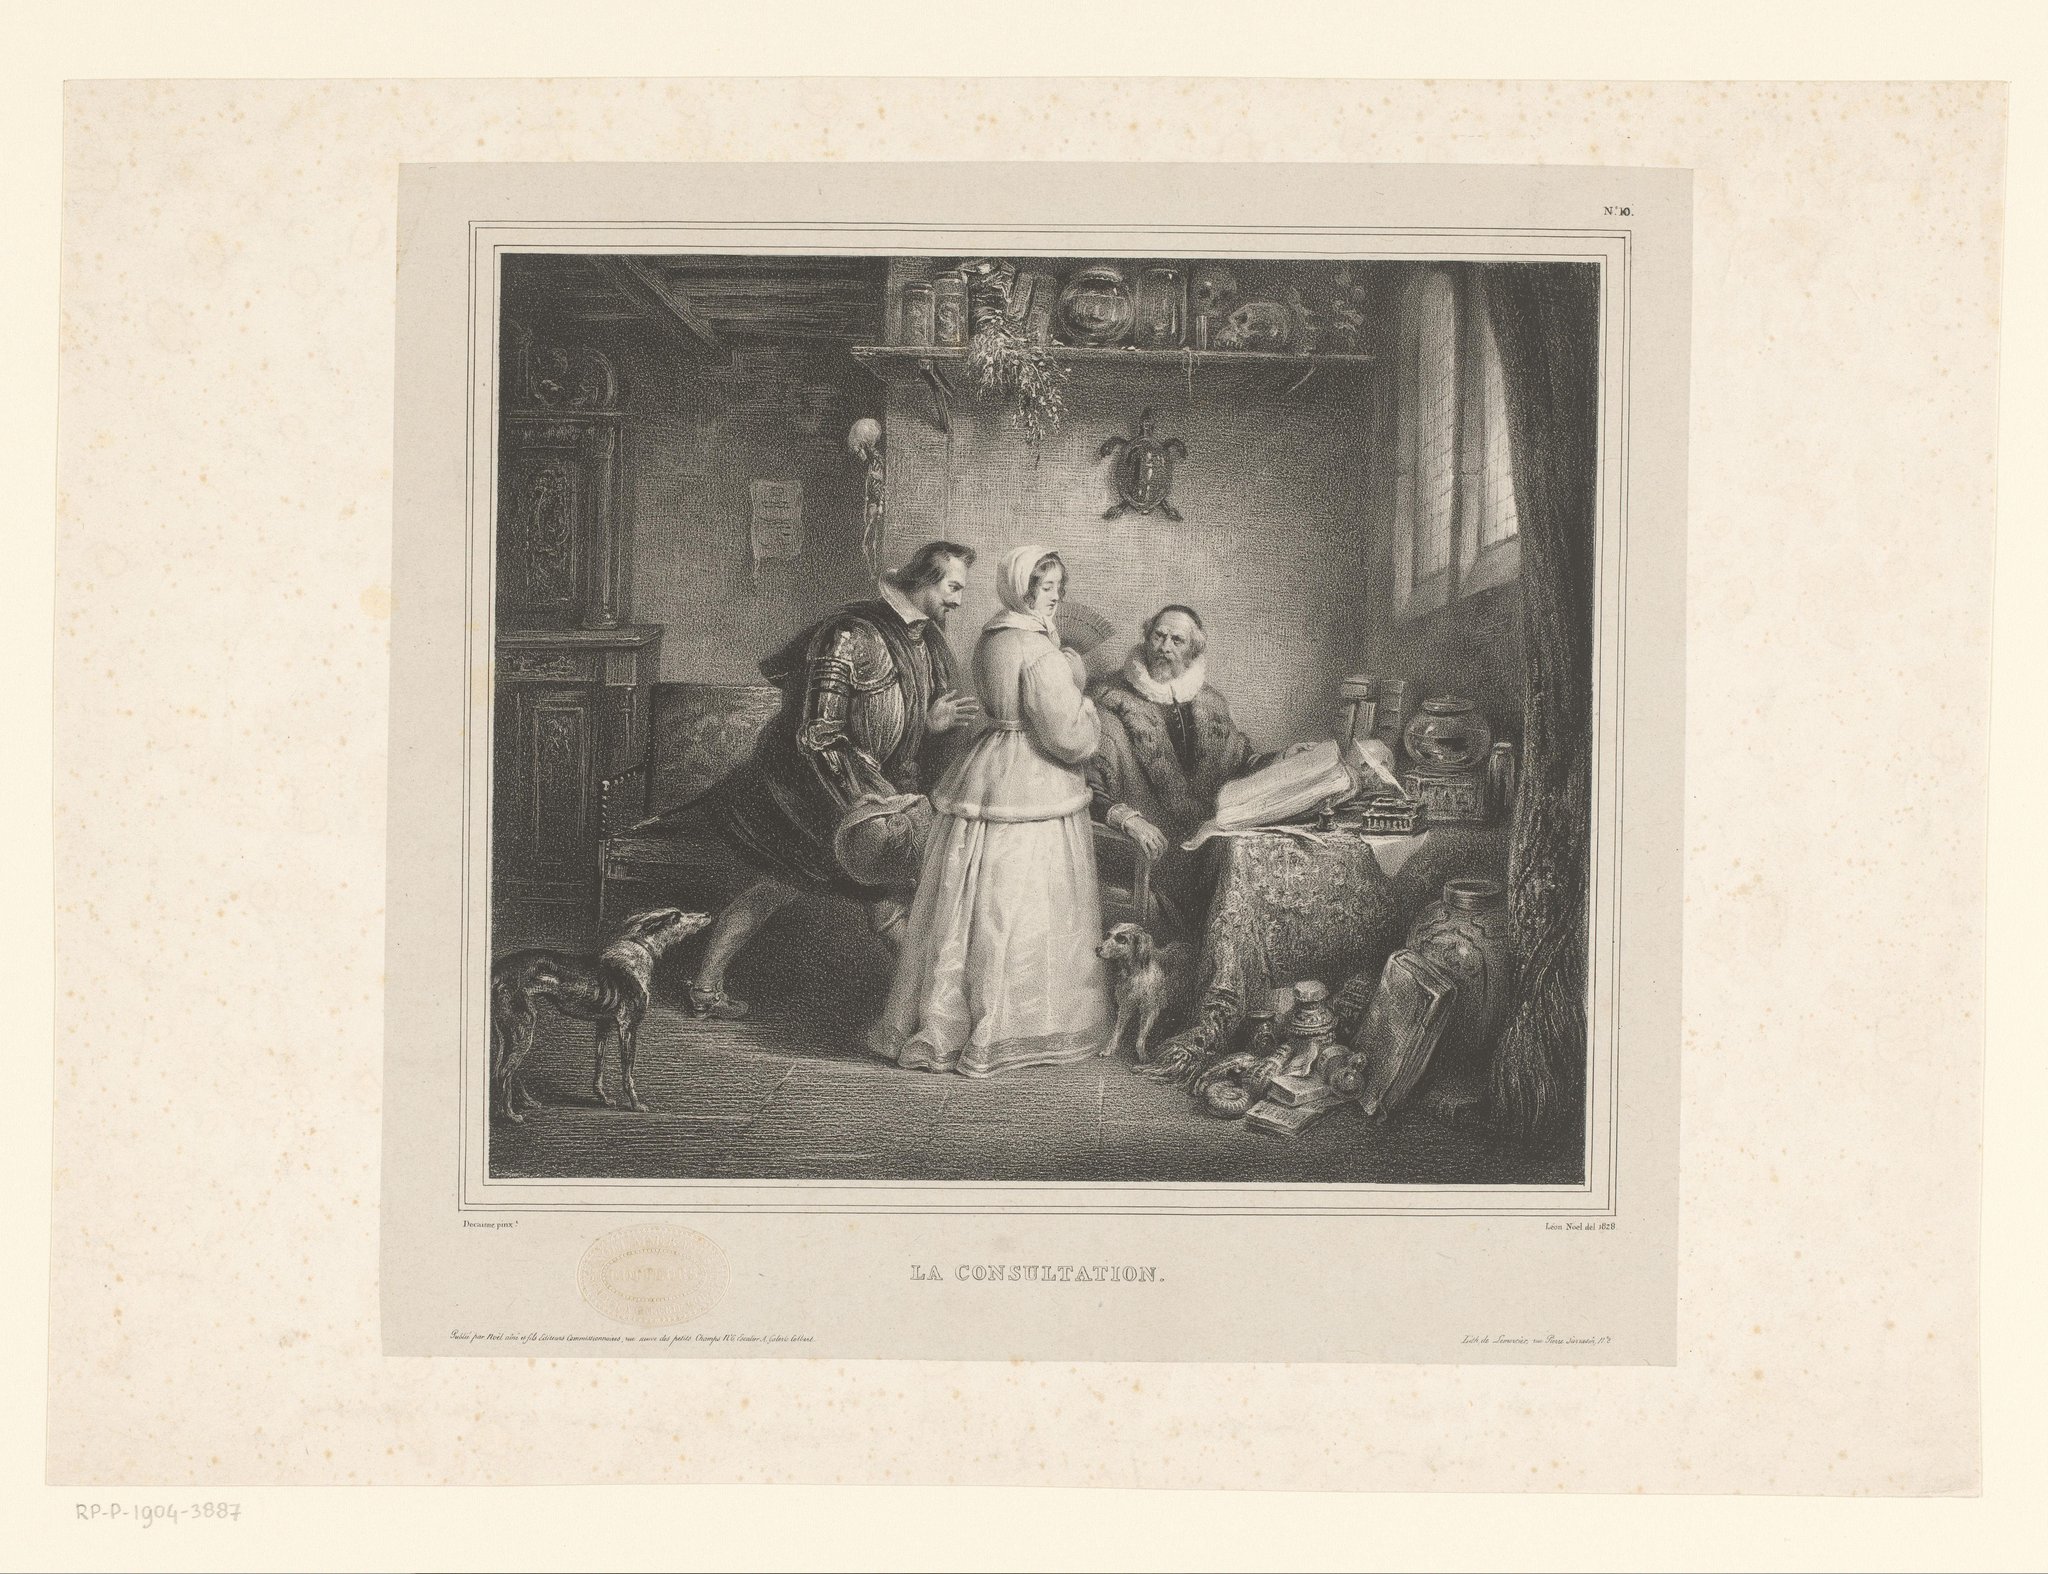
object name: print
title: La consultation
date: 1828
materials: paper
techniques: lithograph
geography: paris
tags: fashion, clothing, interior of the house, dog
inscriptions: collector's mark: Lugt 2228, check stamp: Lugt 4944